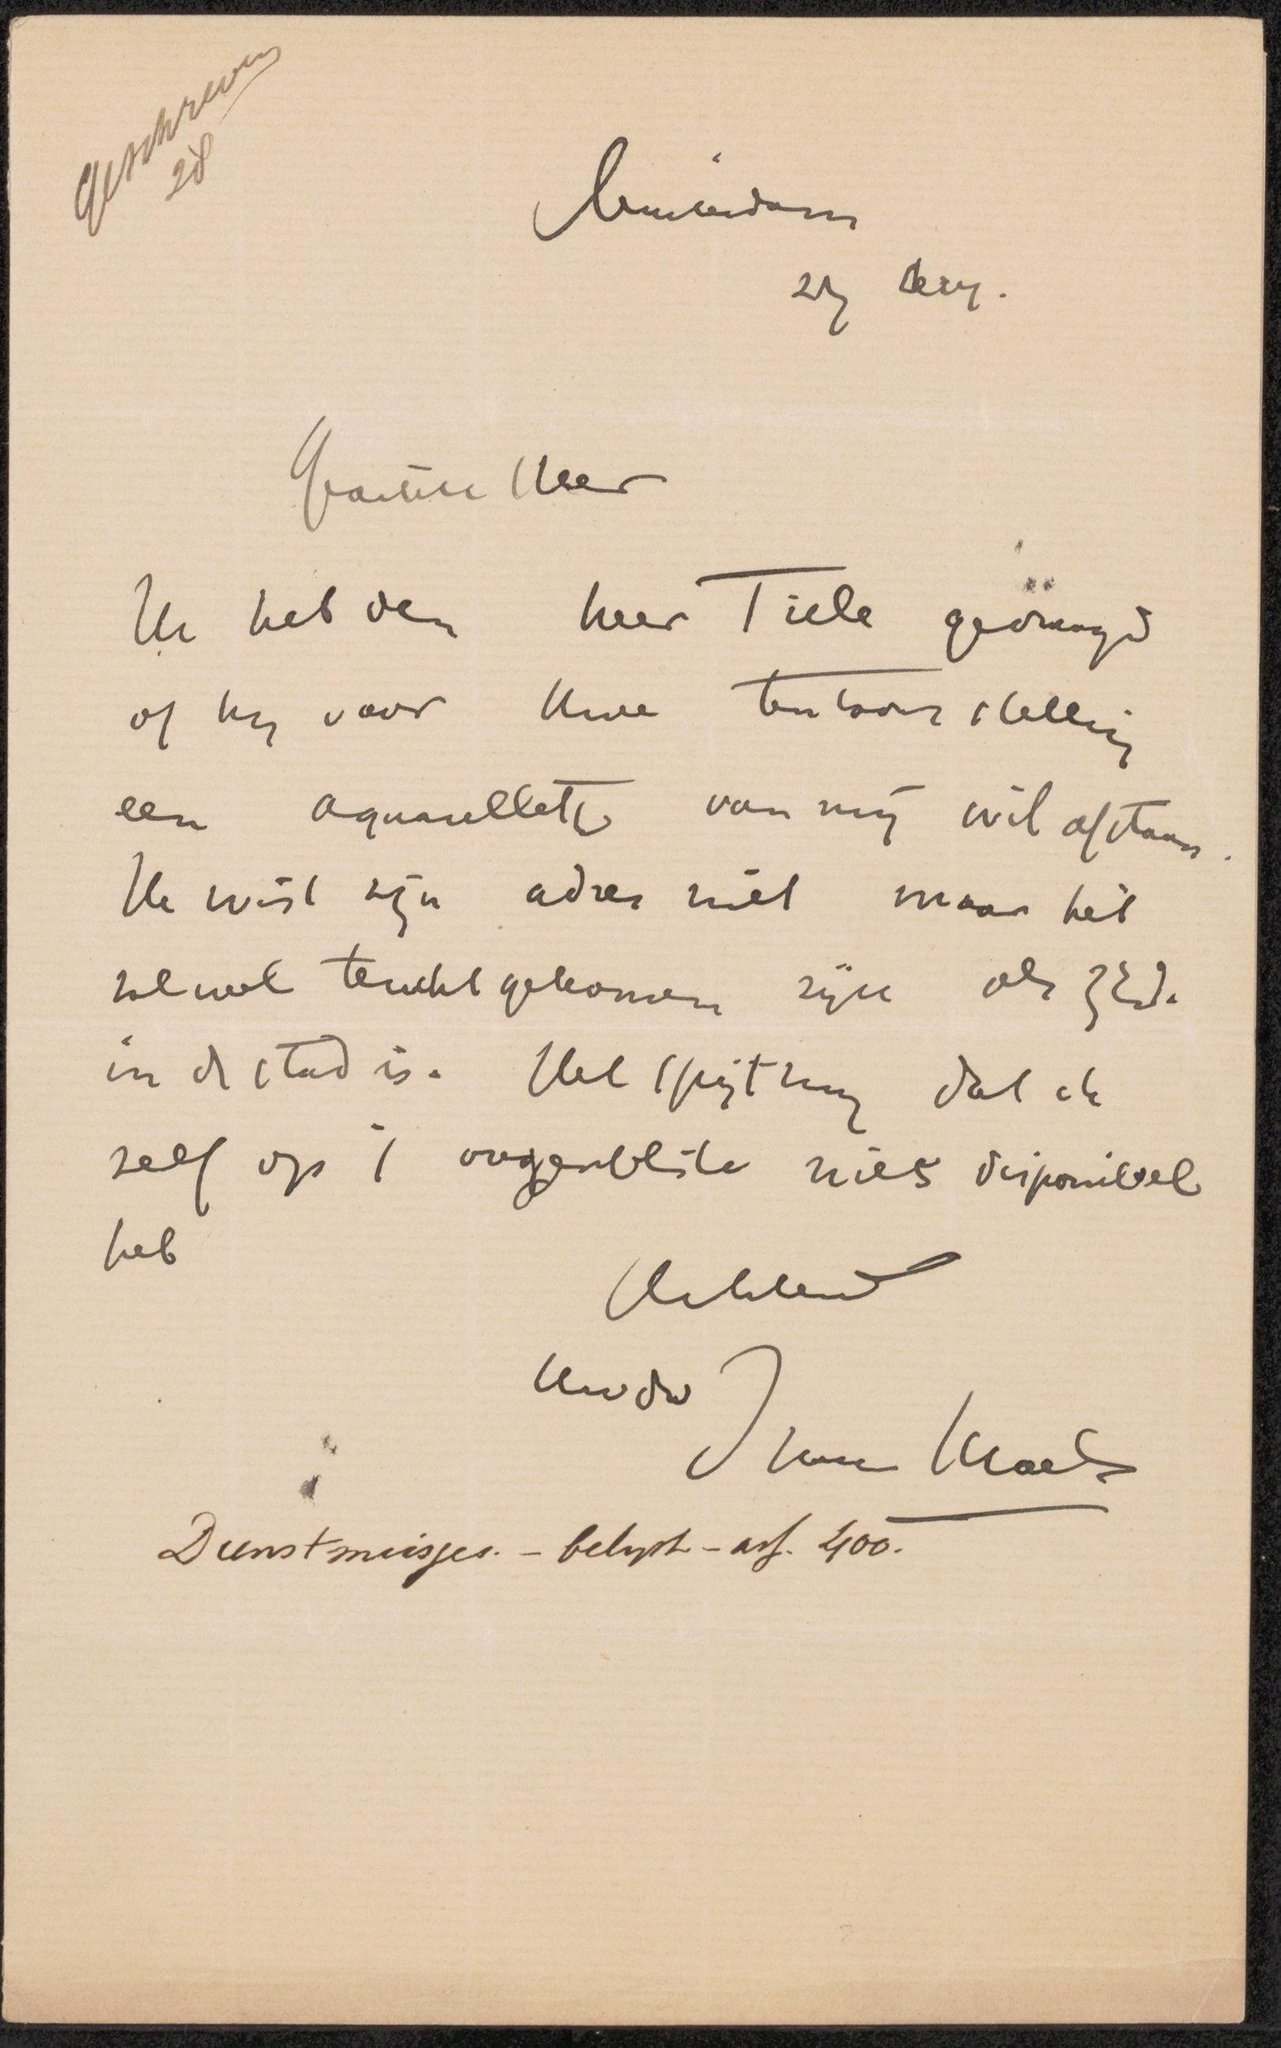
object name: letter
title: Brief aan Pieter Haverkorn van Rijsewijk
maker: isaac israels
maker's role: draughtsman, painter, print maker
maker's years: 1865-1934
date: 1875-1915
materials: ink, paper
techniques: pen, writing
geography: amsterdam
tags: leiden, pieter haverkorn van rijsewijk, drawing, exhibition ~ art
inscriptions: collector's mark: ‘RPK’